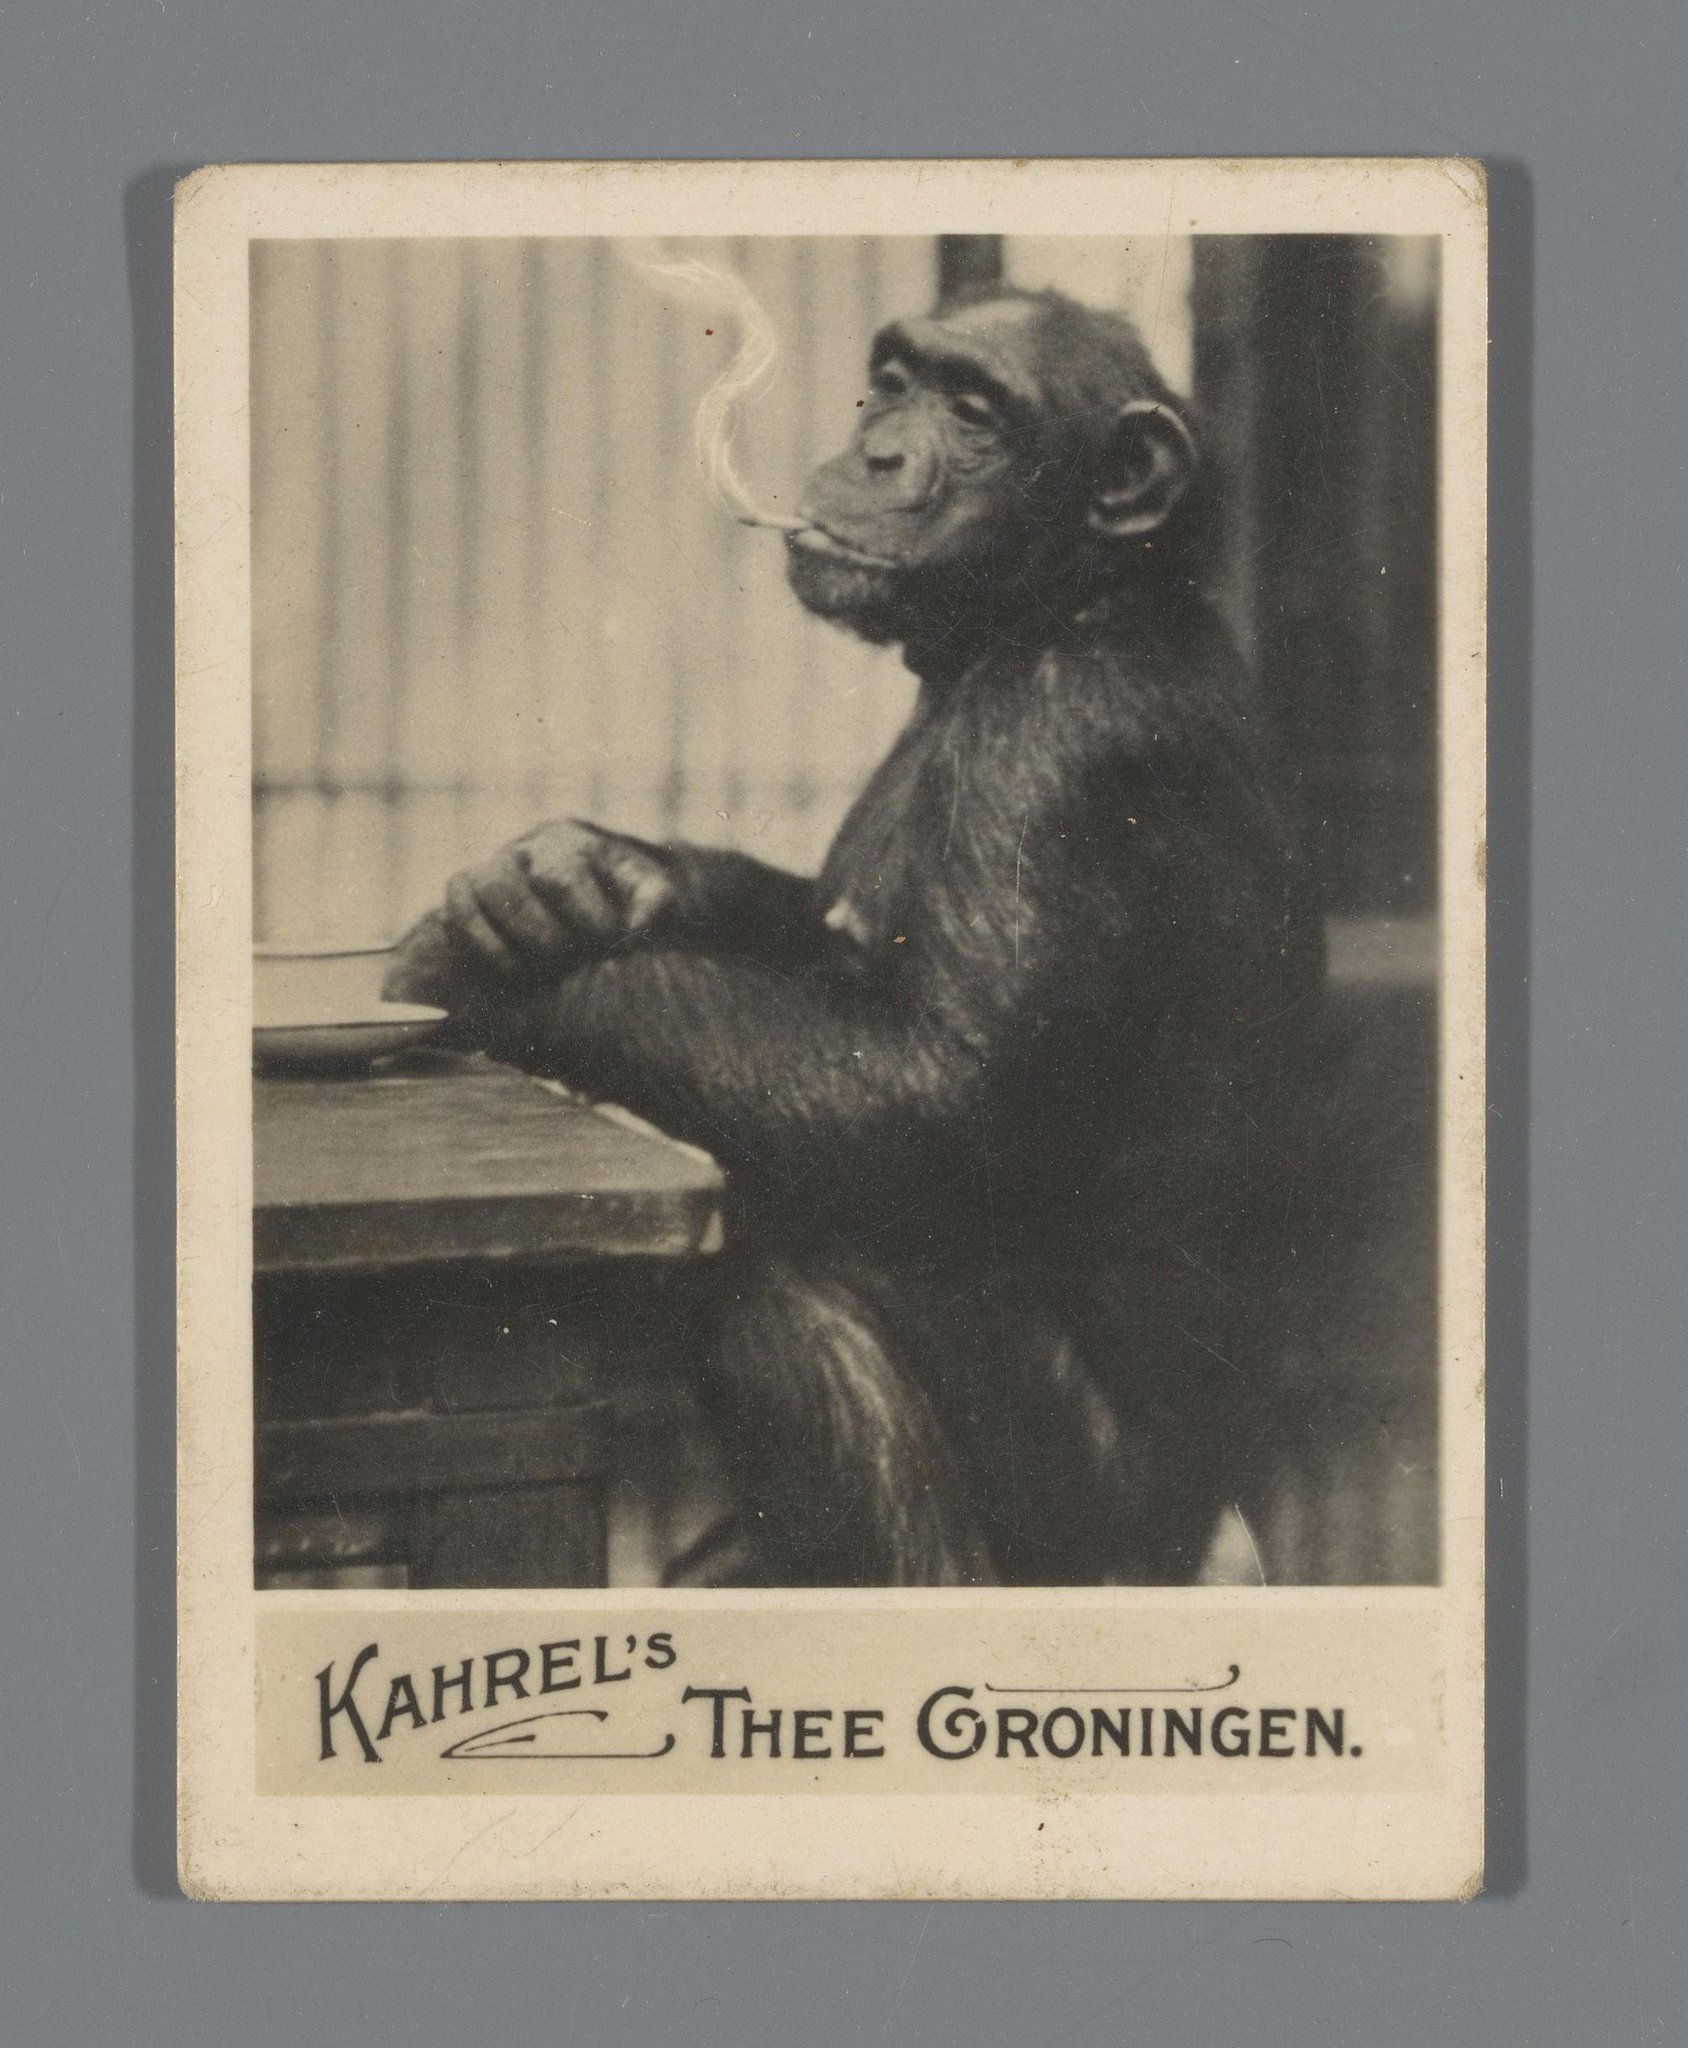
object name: photograph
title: Rokende chimpansee, reclame voor Kahrel's Thee Groningen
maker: Anonymous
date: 1895-1910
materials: paper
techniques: gelatin silver print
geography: groningen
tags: cigarette, monkeys, apes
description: Dergelijke foto's stonden bekend als 'zwartjes'. Men verkreeg ze bij aanschaf van bepaalde merken thee, cacao, sigaretten, beschuit, etc. om te verzamelen. Er waren speciaal voor de 'zwartjes' verzamelalbums in omloop.